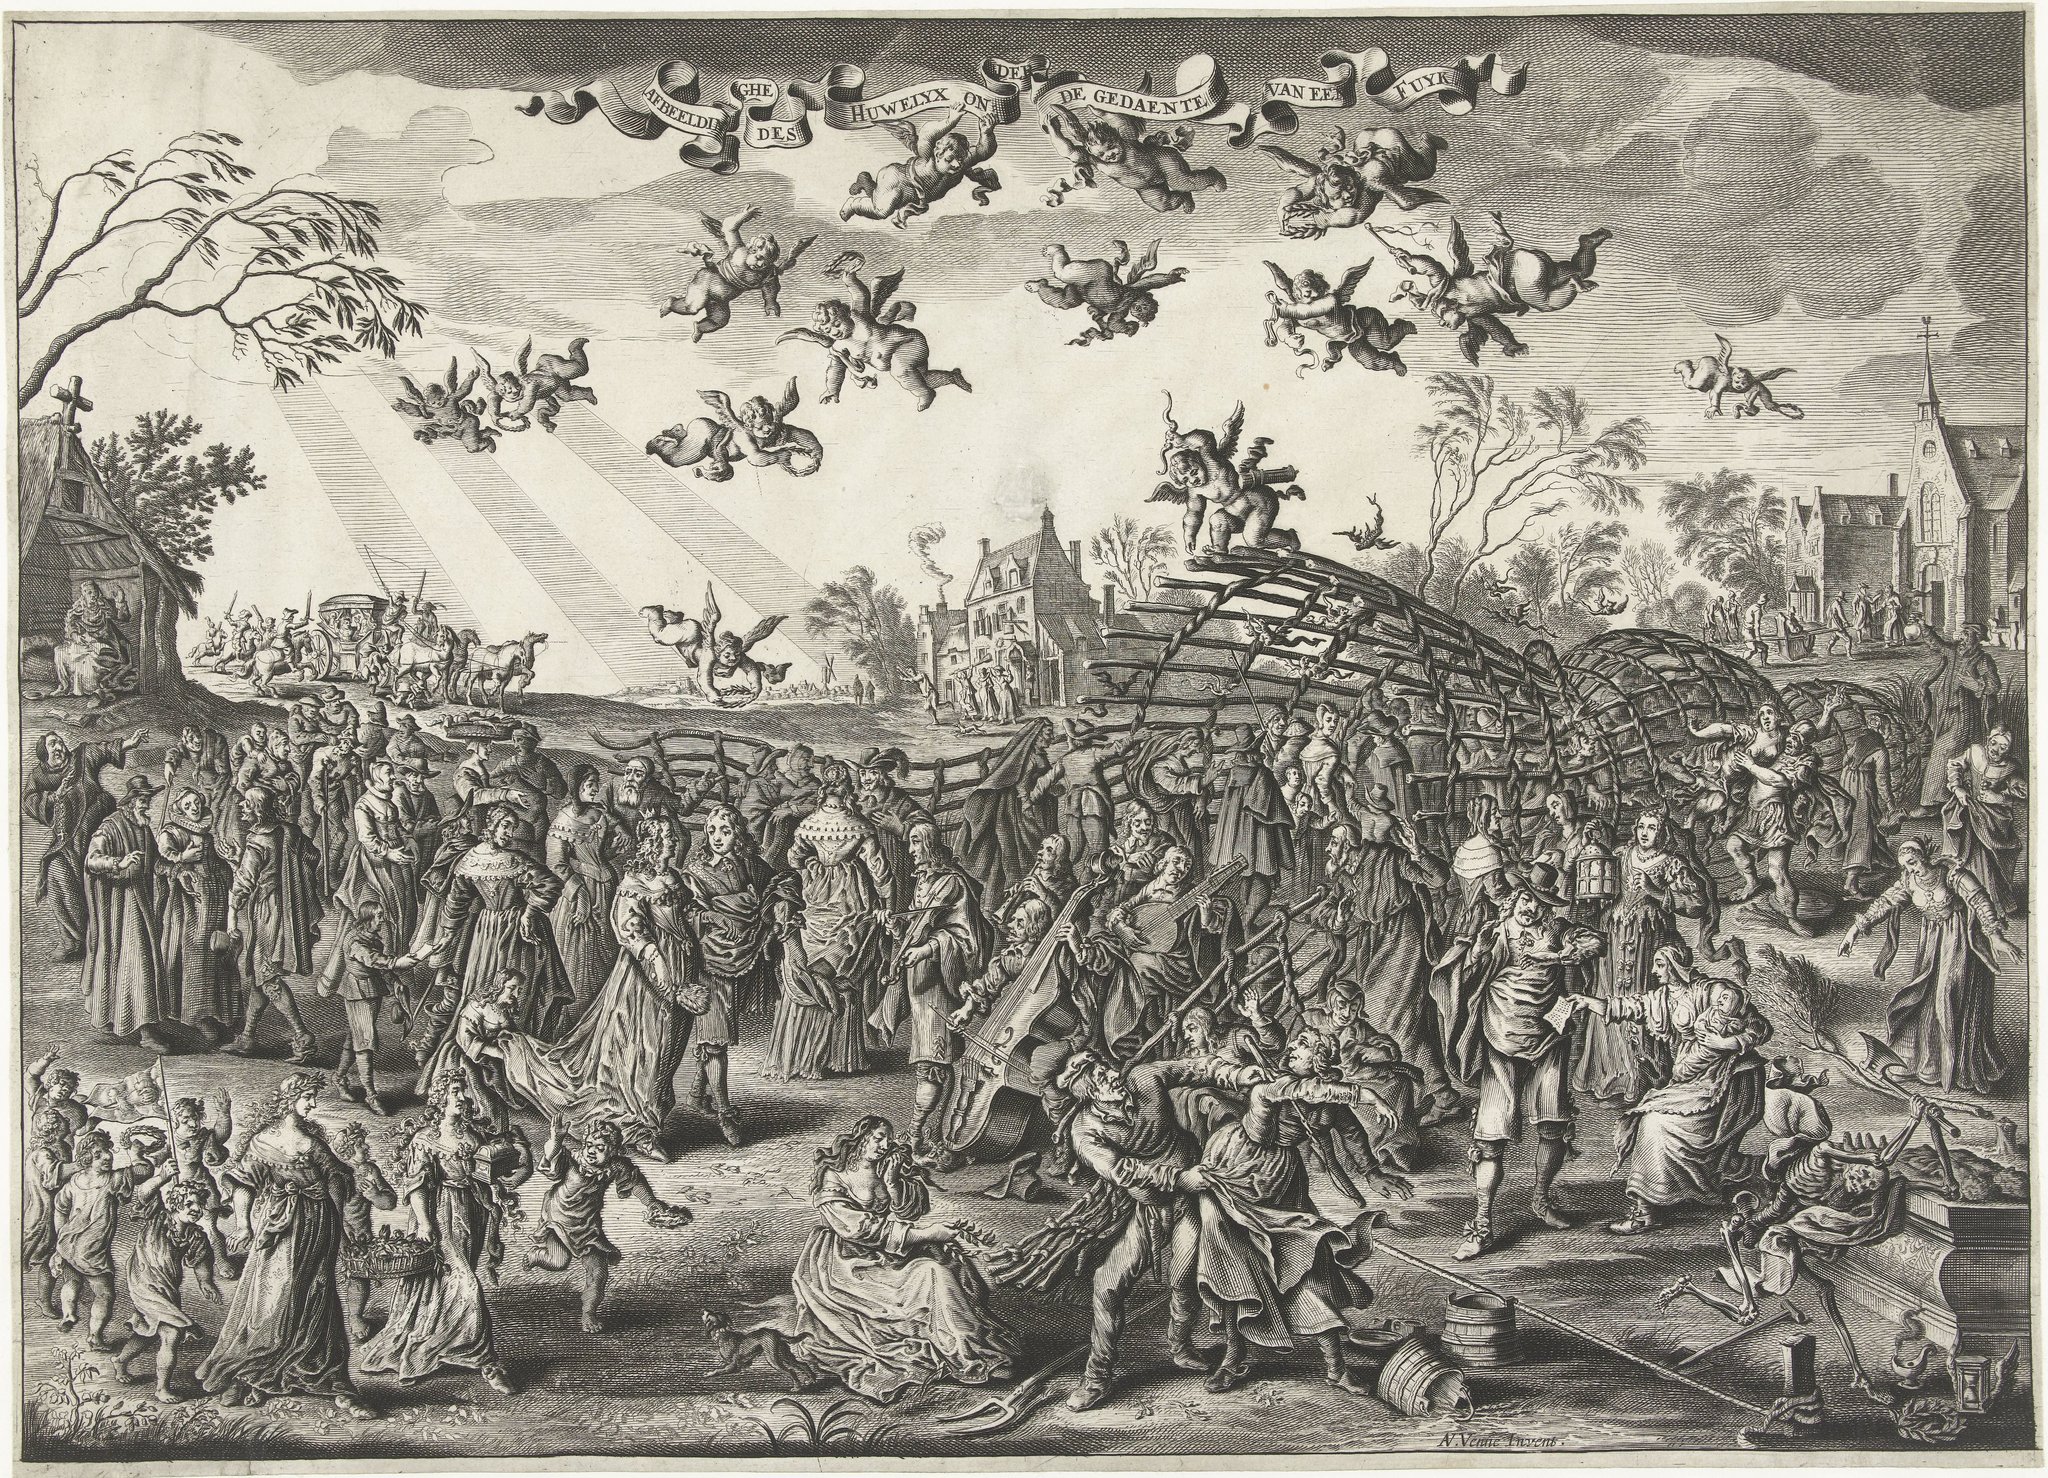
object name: print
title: De huwelijksfuik: allegorie op het huwelijk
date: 1655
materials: paper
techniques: engraving, etching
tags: marriage, married couple, 'matrimonium'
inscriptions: collector's mark: Lugt 2228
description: De huwelijksfuik, allegorie op het huwelijk. Paren lopen gearmd een grote fuik of vangnet binnen onder begeleiding van muziek van een klein orkest. Bovenop de fuik zit Cupido. Putti dansen rond een bruidspaar met bloemenmand. Om de fuik lopen mannen en vrouwen, zij maken allerlei erotische toespelingen. rechts zwaait de Dood met een hakbijl.